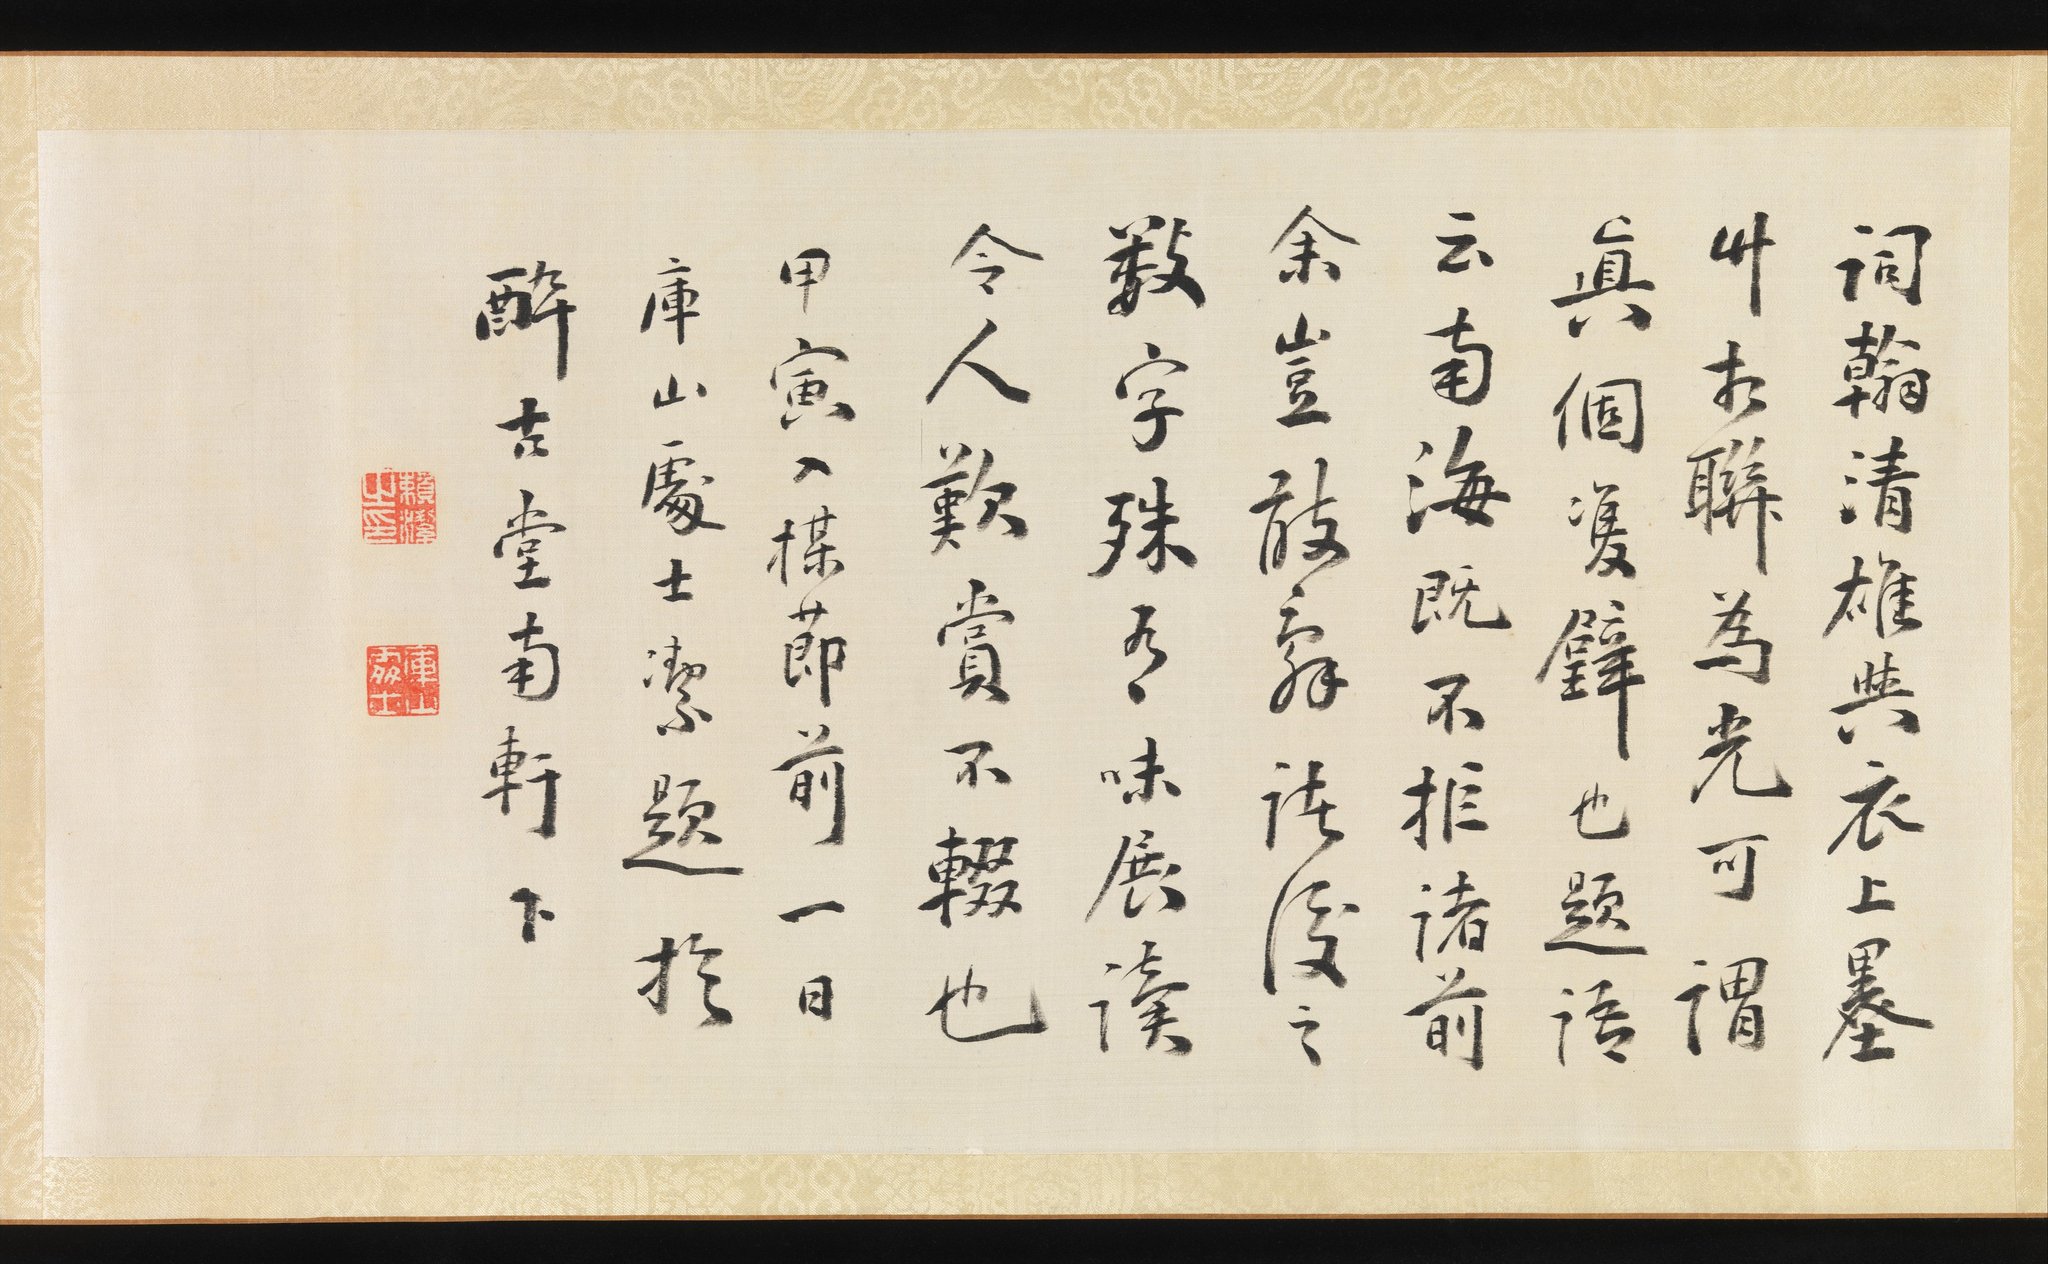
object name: handscroll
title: Poem Accompanying an Over Robe (Uchikake) with a Bamboo Painting by Gion Nankai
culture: japanese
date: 1824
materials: ink, paper